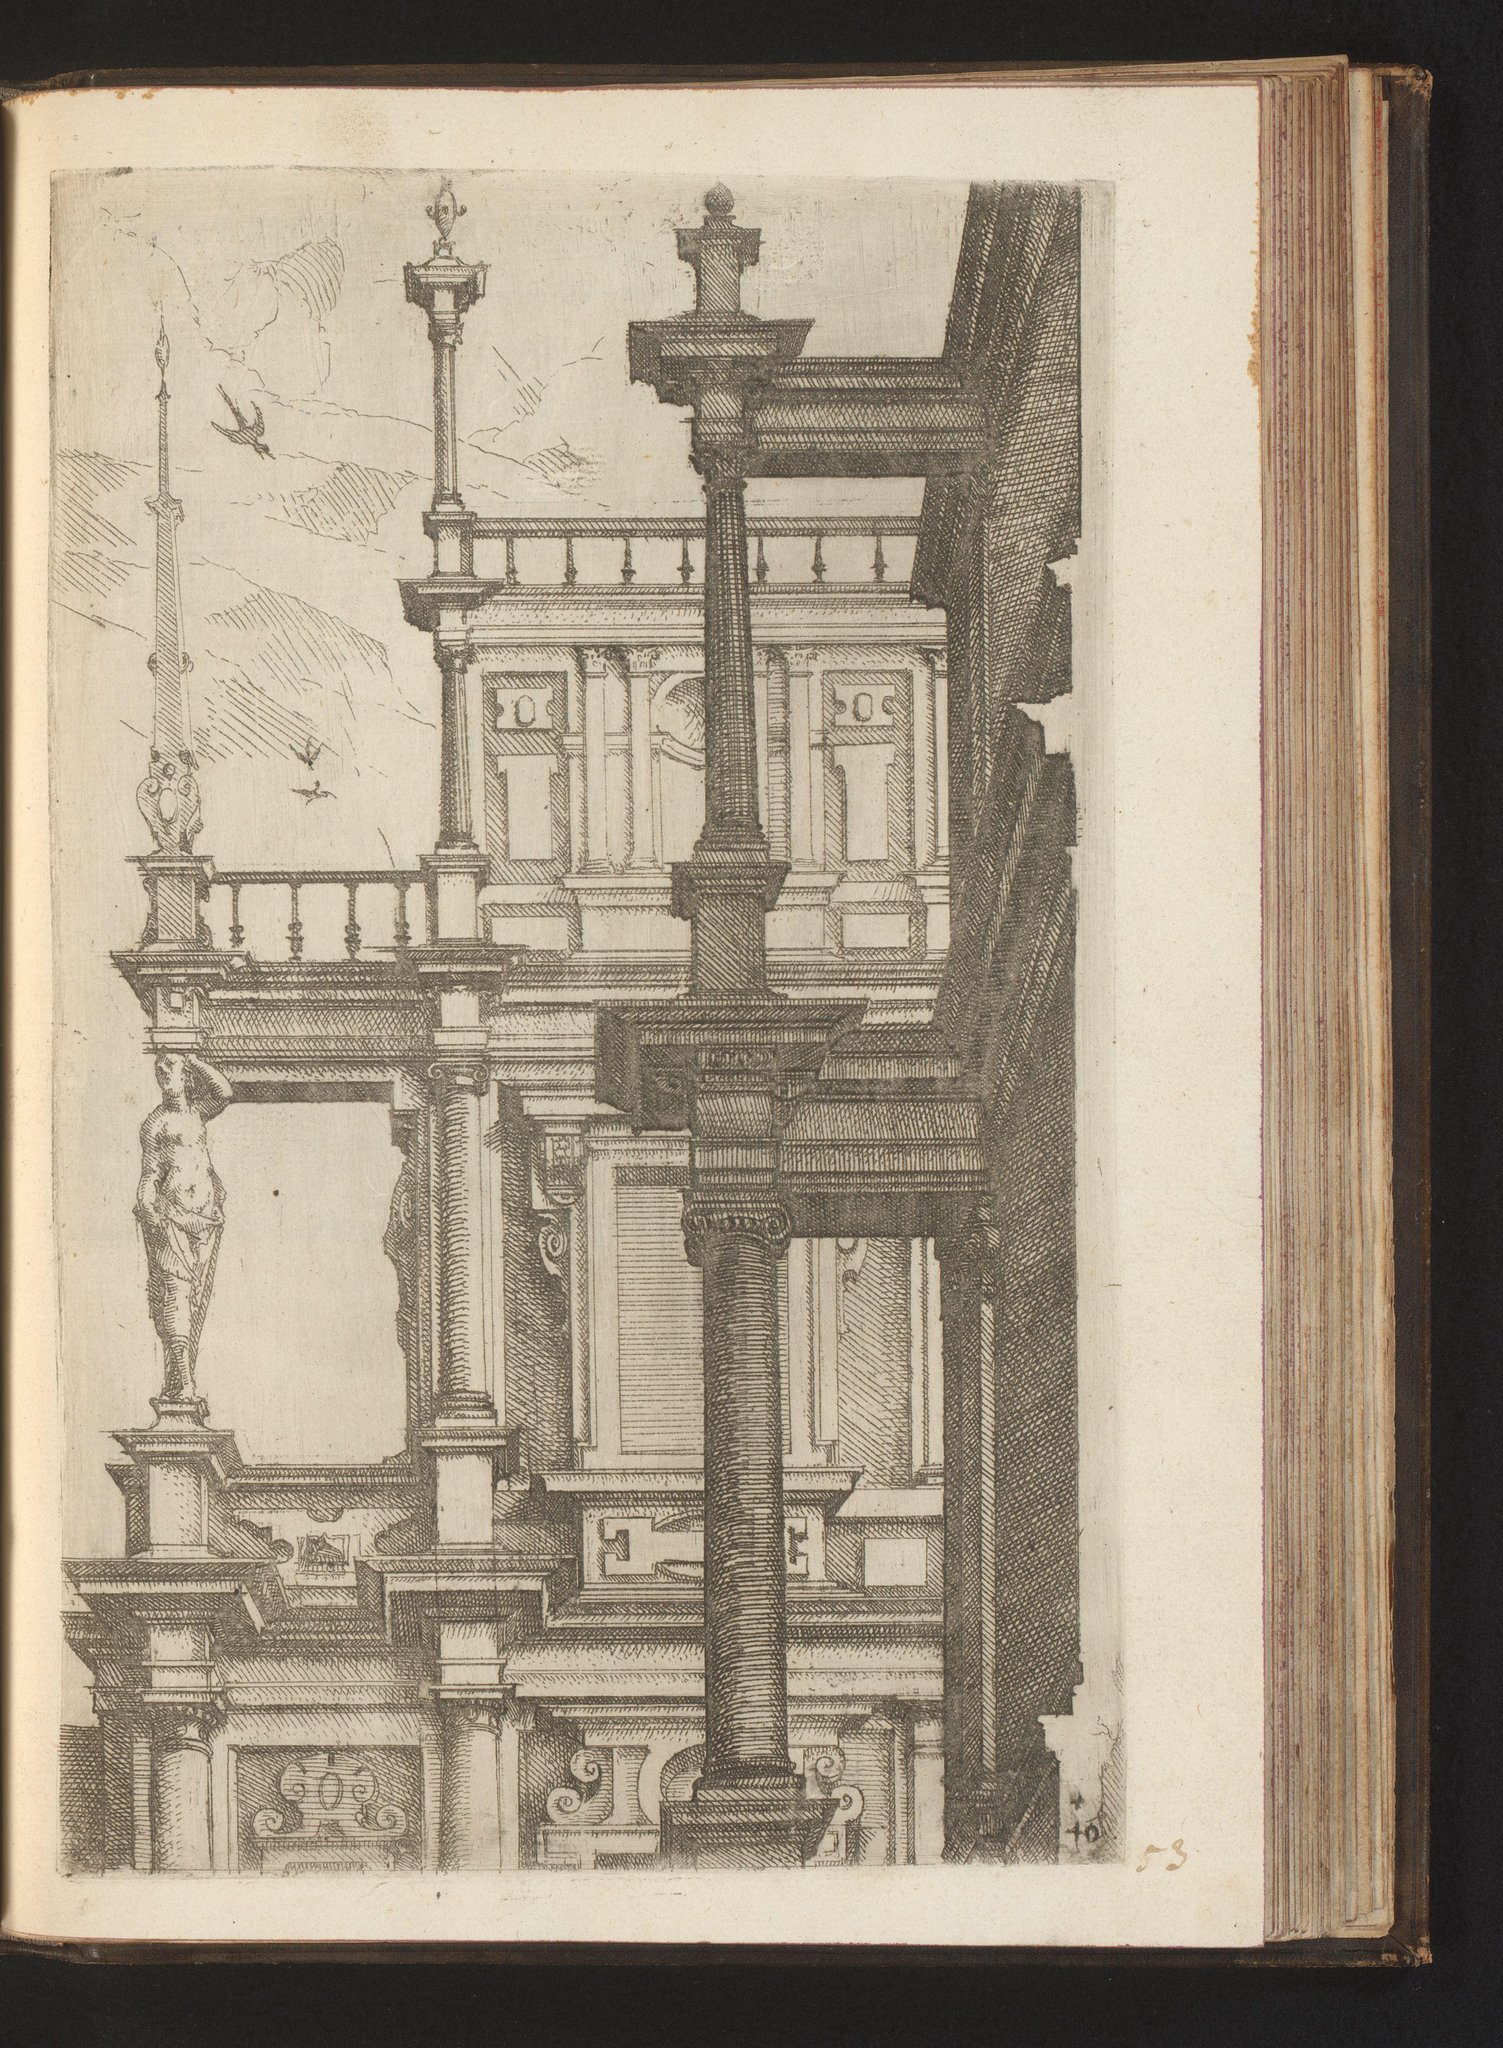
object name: book illustration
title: Architectura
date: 1593-1595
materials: paper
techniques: etching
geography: straatsburg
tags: composite order ~ architecture, caryatids ~ architecture, other architectural details, ionic order ~ architecture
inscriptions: collector's mark: Lugt 2760, collector's mark: Lugt 2228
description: Prent gebruikt in: Dietterlin, Wendel (I). Architectura de quinq[ue] columnarum simmetrica distributione et variis eorundem or namentis: Liber I. Straatsburg: Bernhard Jobin, 1593.